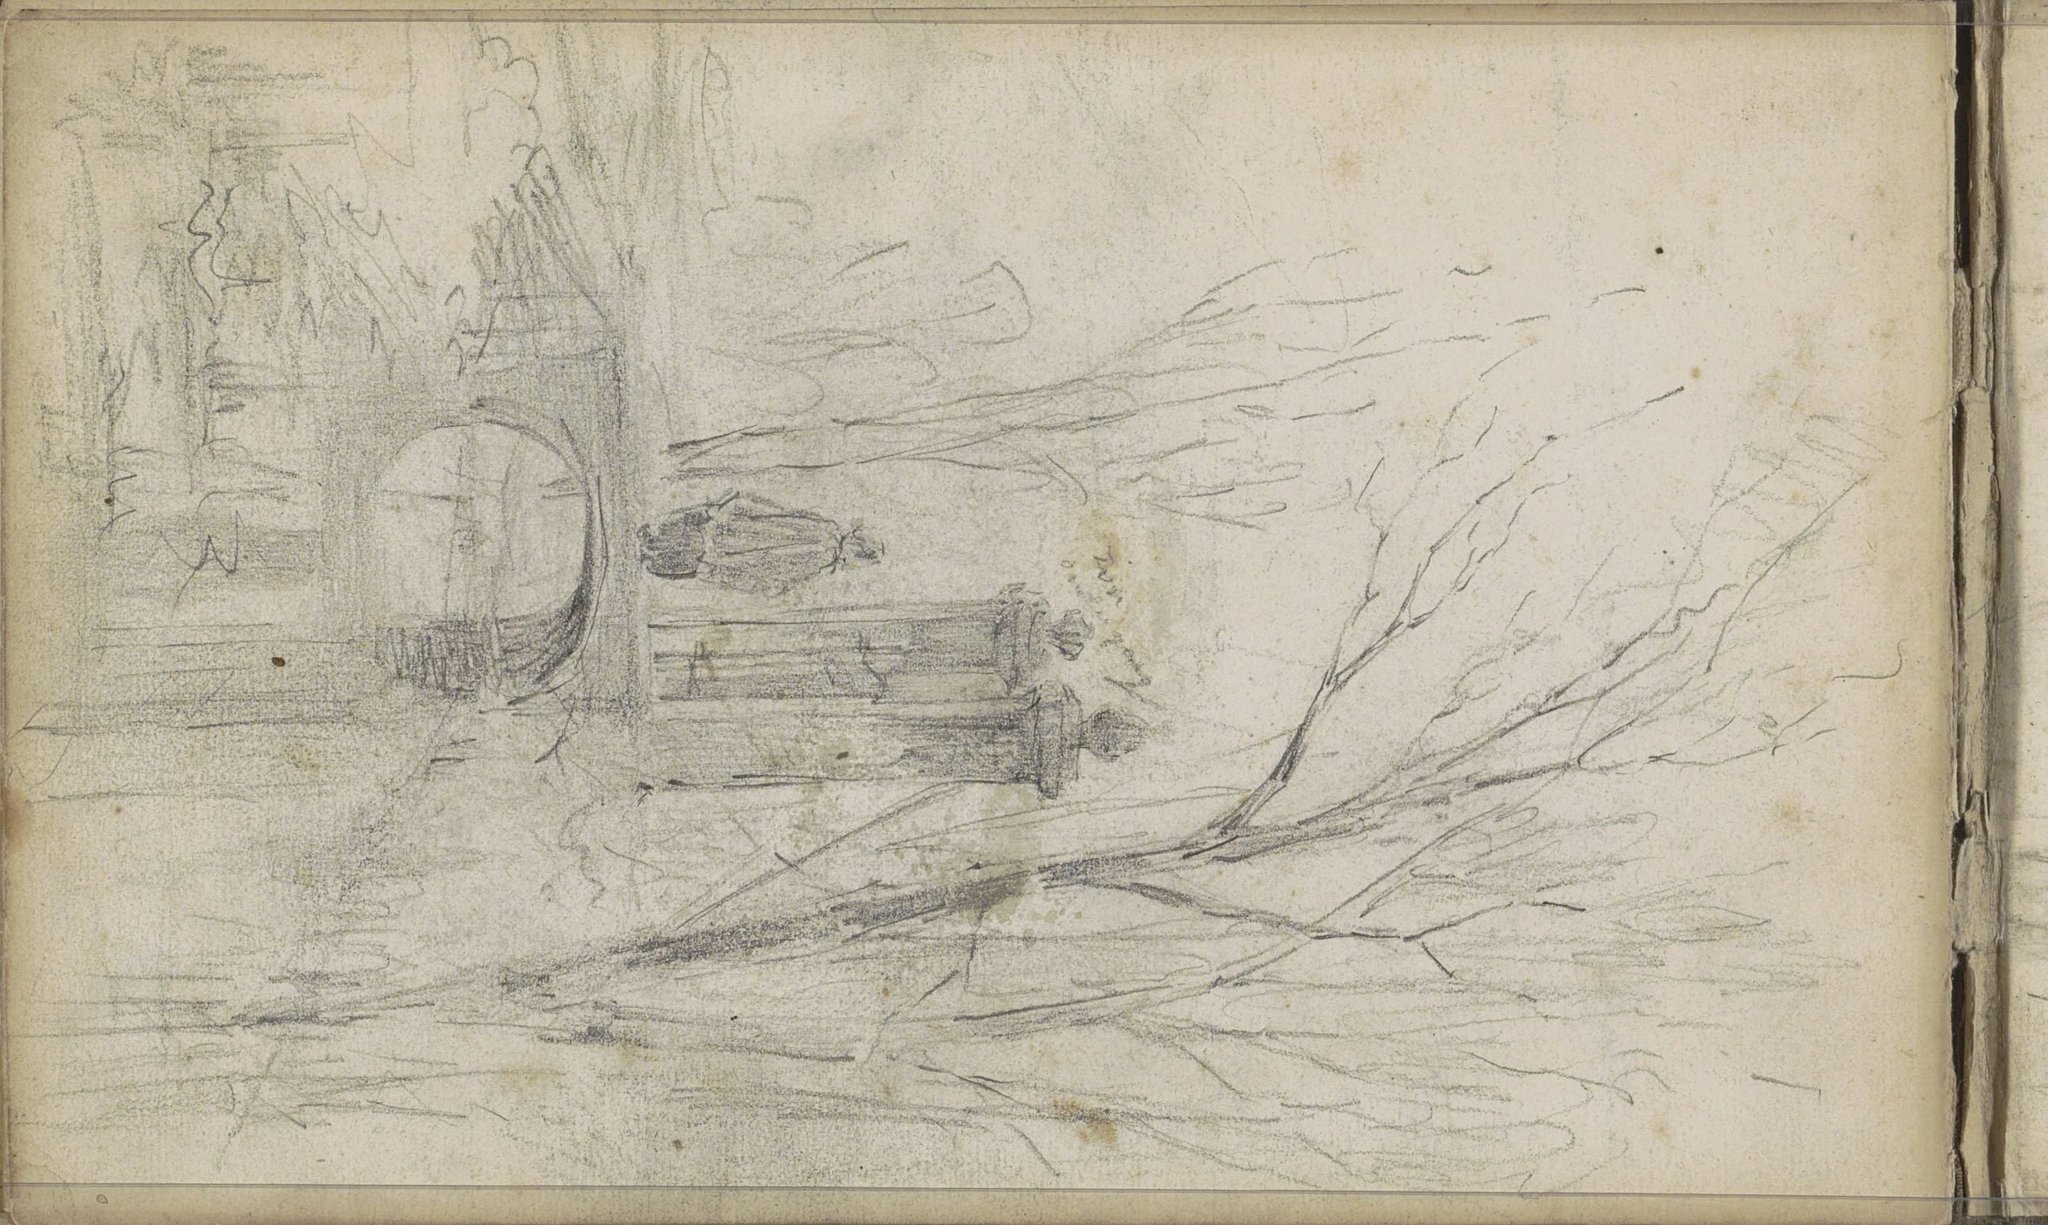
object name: sketchbook leaf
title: Vrouw bij een poort op een brug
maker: willem cornelis rip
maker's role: draughtsman, painter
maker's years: 1856-1922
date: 1876-1877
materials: paper, pencil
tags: gate, entrance, bridge, landscapes with waters, waterscapes, seascapes (in the temperate zone) (+ landscape with figures, staffage)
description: Blad 41 verso uit een schetsboek met 41 bladen.